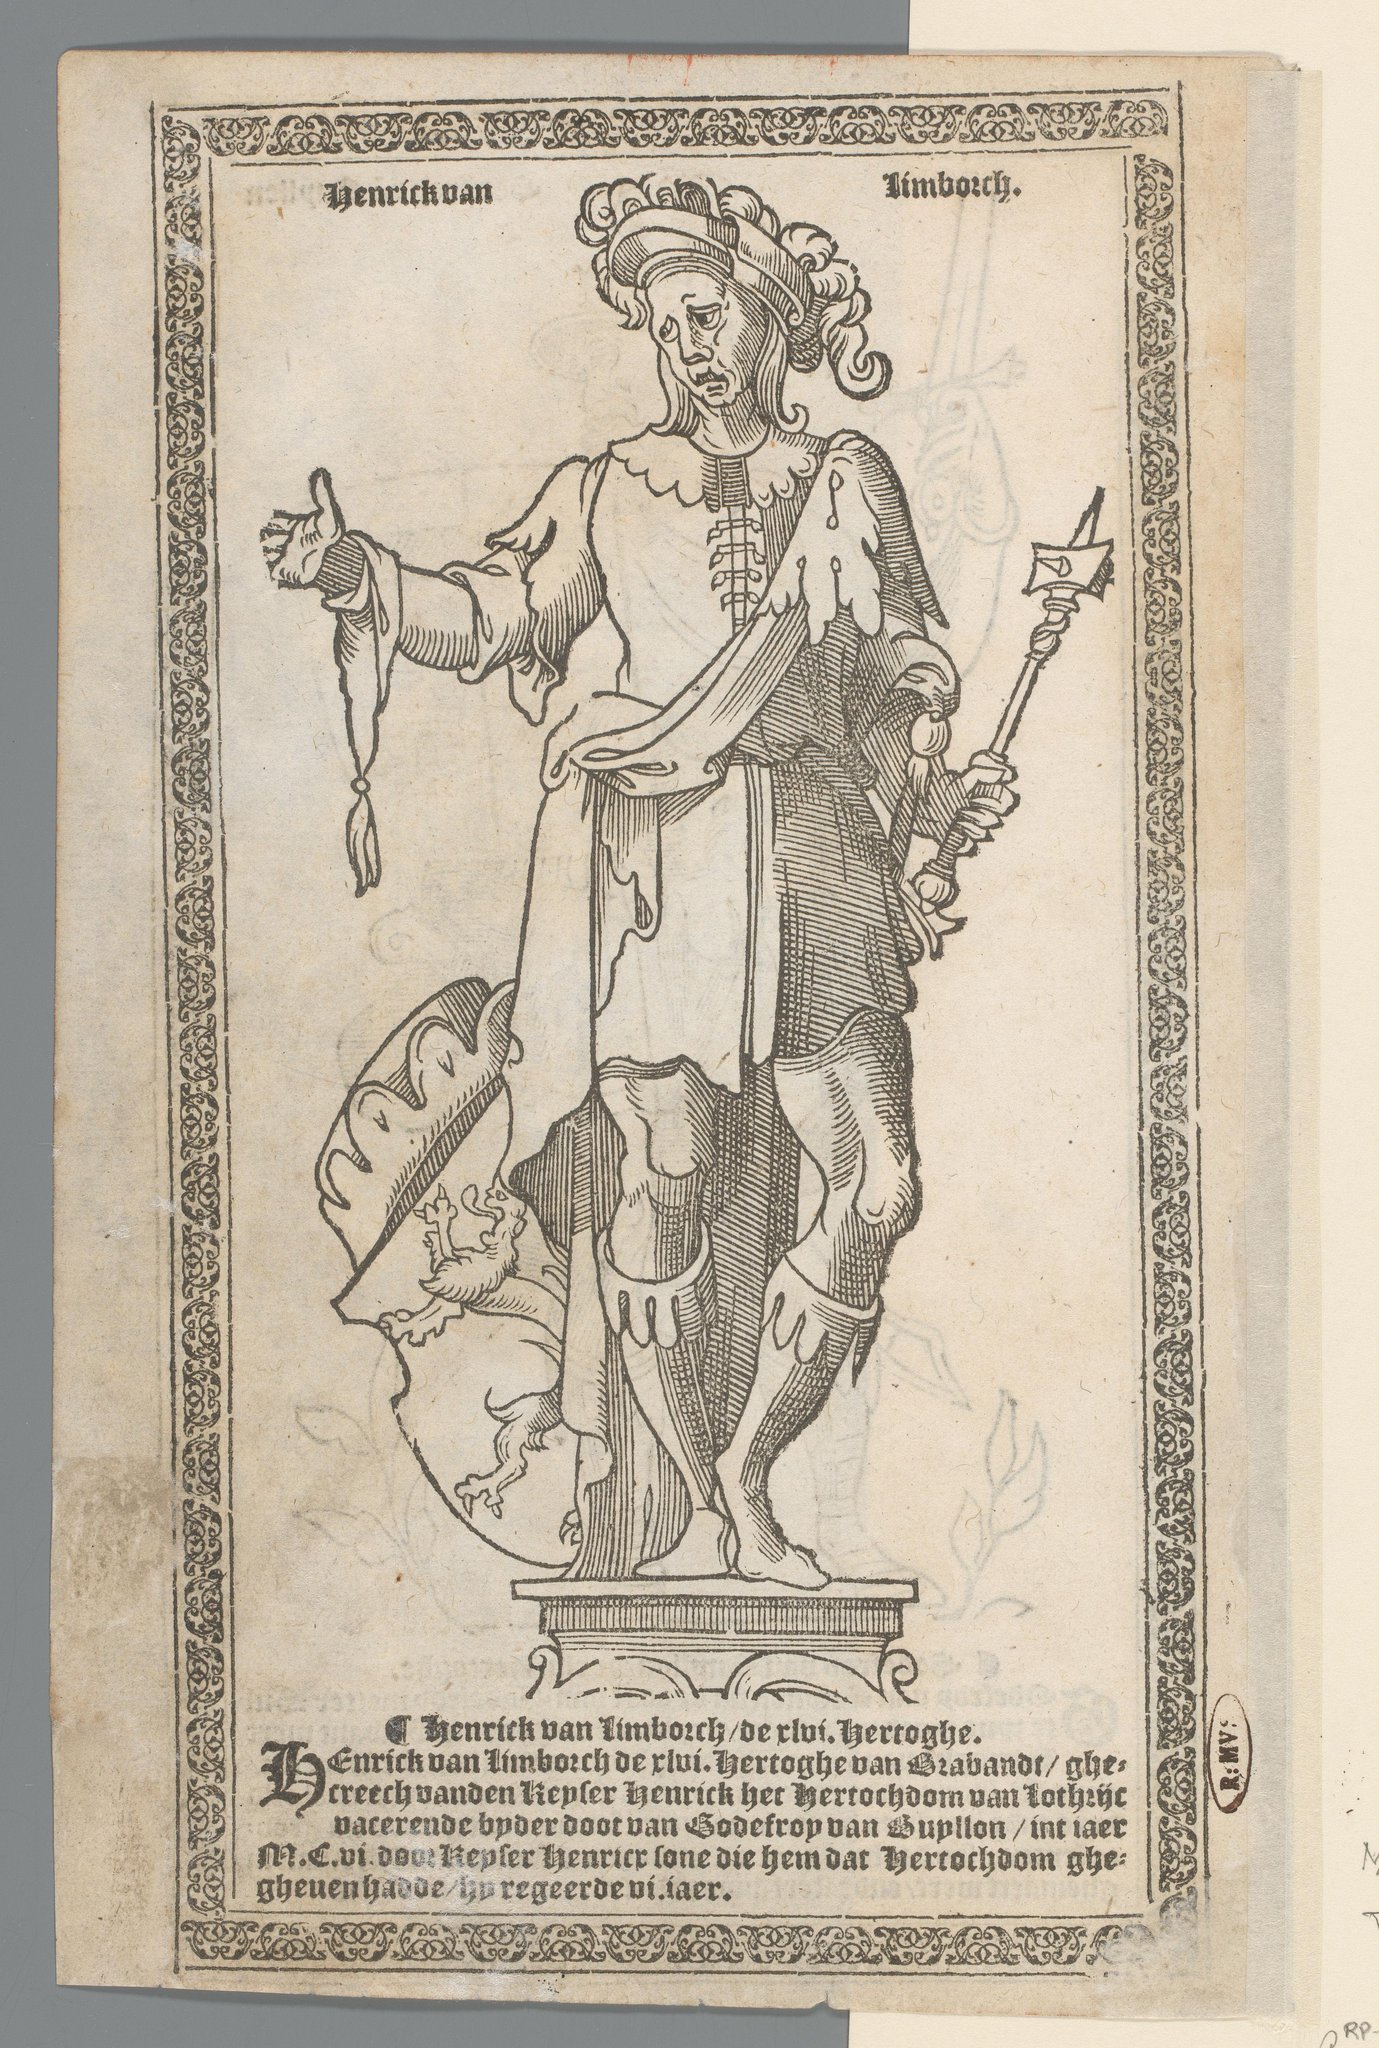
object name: print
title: Portret van Hendrik I van Limburg, hertog van Neder-Lotharingen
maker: jan molijns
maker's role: print maker, publisher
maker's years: 1498-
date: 1565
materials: paper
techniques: letterpress printing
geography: antwerp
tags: historical persons, armorial bearing, heraldry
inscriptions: collector's mark: Lugt 2228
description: Prent uit: Dit is die afcoemste ende genalogie der hertoghen ende hertoginnen van Brabandt, (...). Antwerpen: Jan Molijns, 1565.